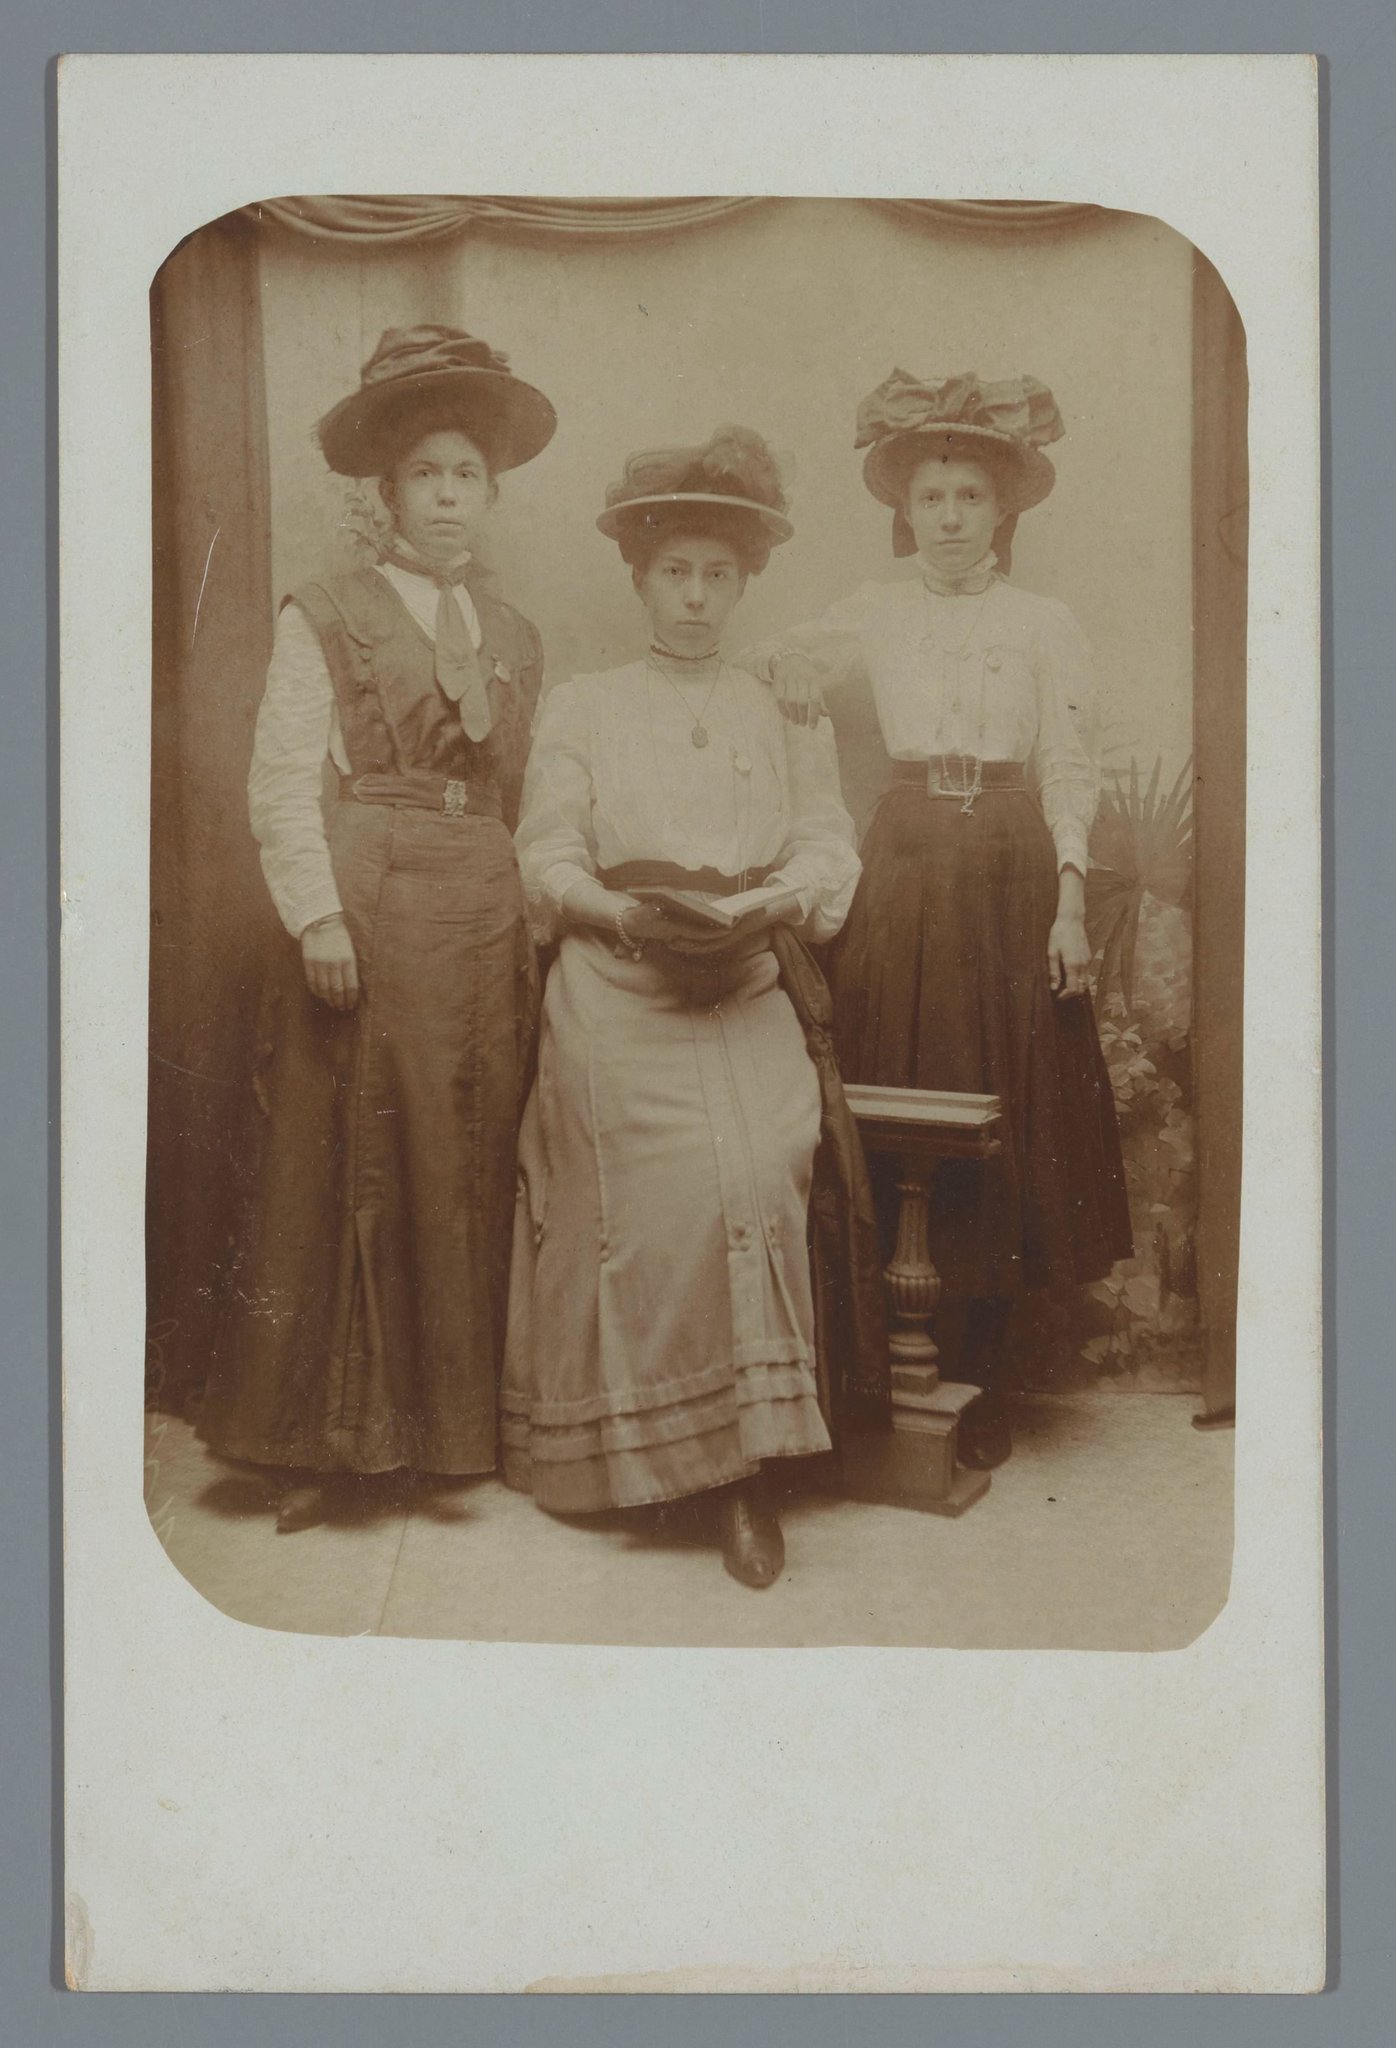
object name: ansichtkaart, prentbriefkaart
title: Studioportret van drie onbekende vrouwen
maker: Anonymous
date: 1907-1920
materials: photographic support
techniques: gelatin silver print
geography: amsterdam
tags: adult woman, anonymous historical persons portrayed in a group, in a group-portrait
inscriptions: inscription: ‘,,Foto'' 2e Oosterparkstraat, 143’